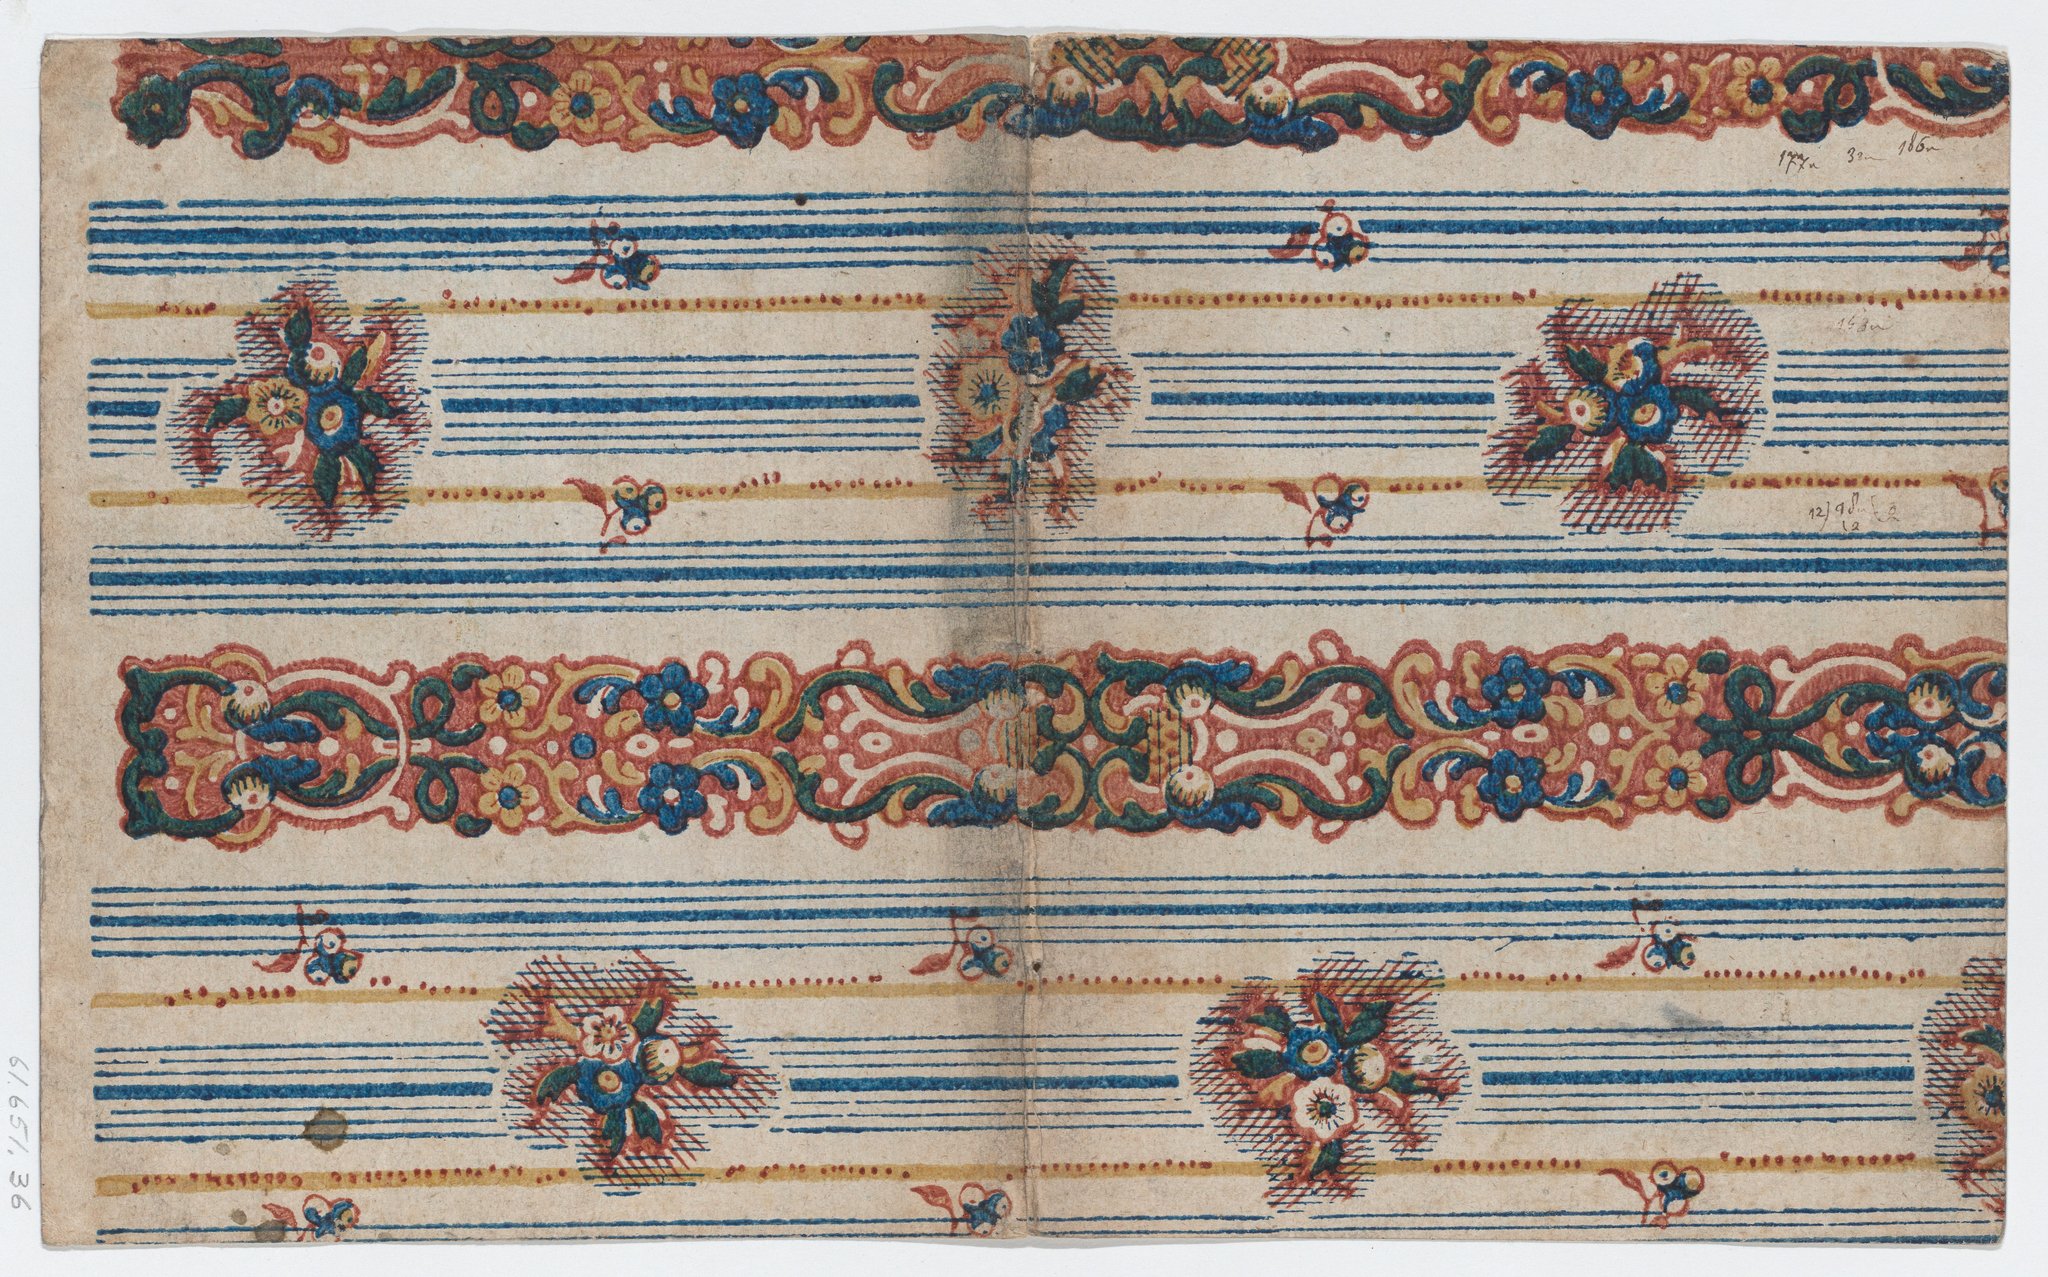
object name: print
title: Book cover with overall striped and floral design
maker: Anonymous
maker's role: artist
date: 1801-1900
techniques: relief print